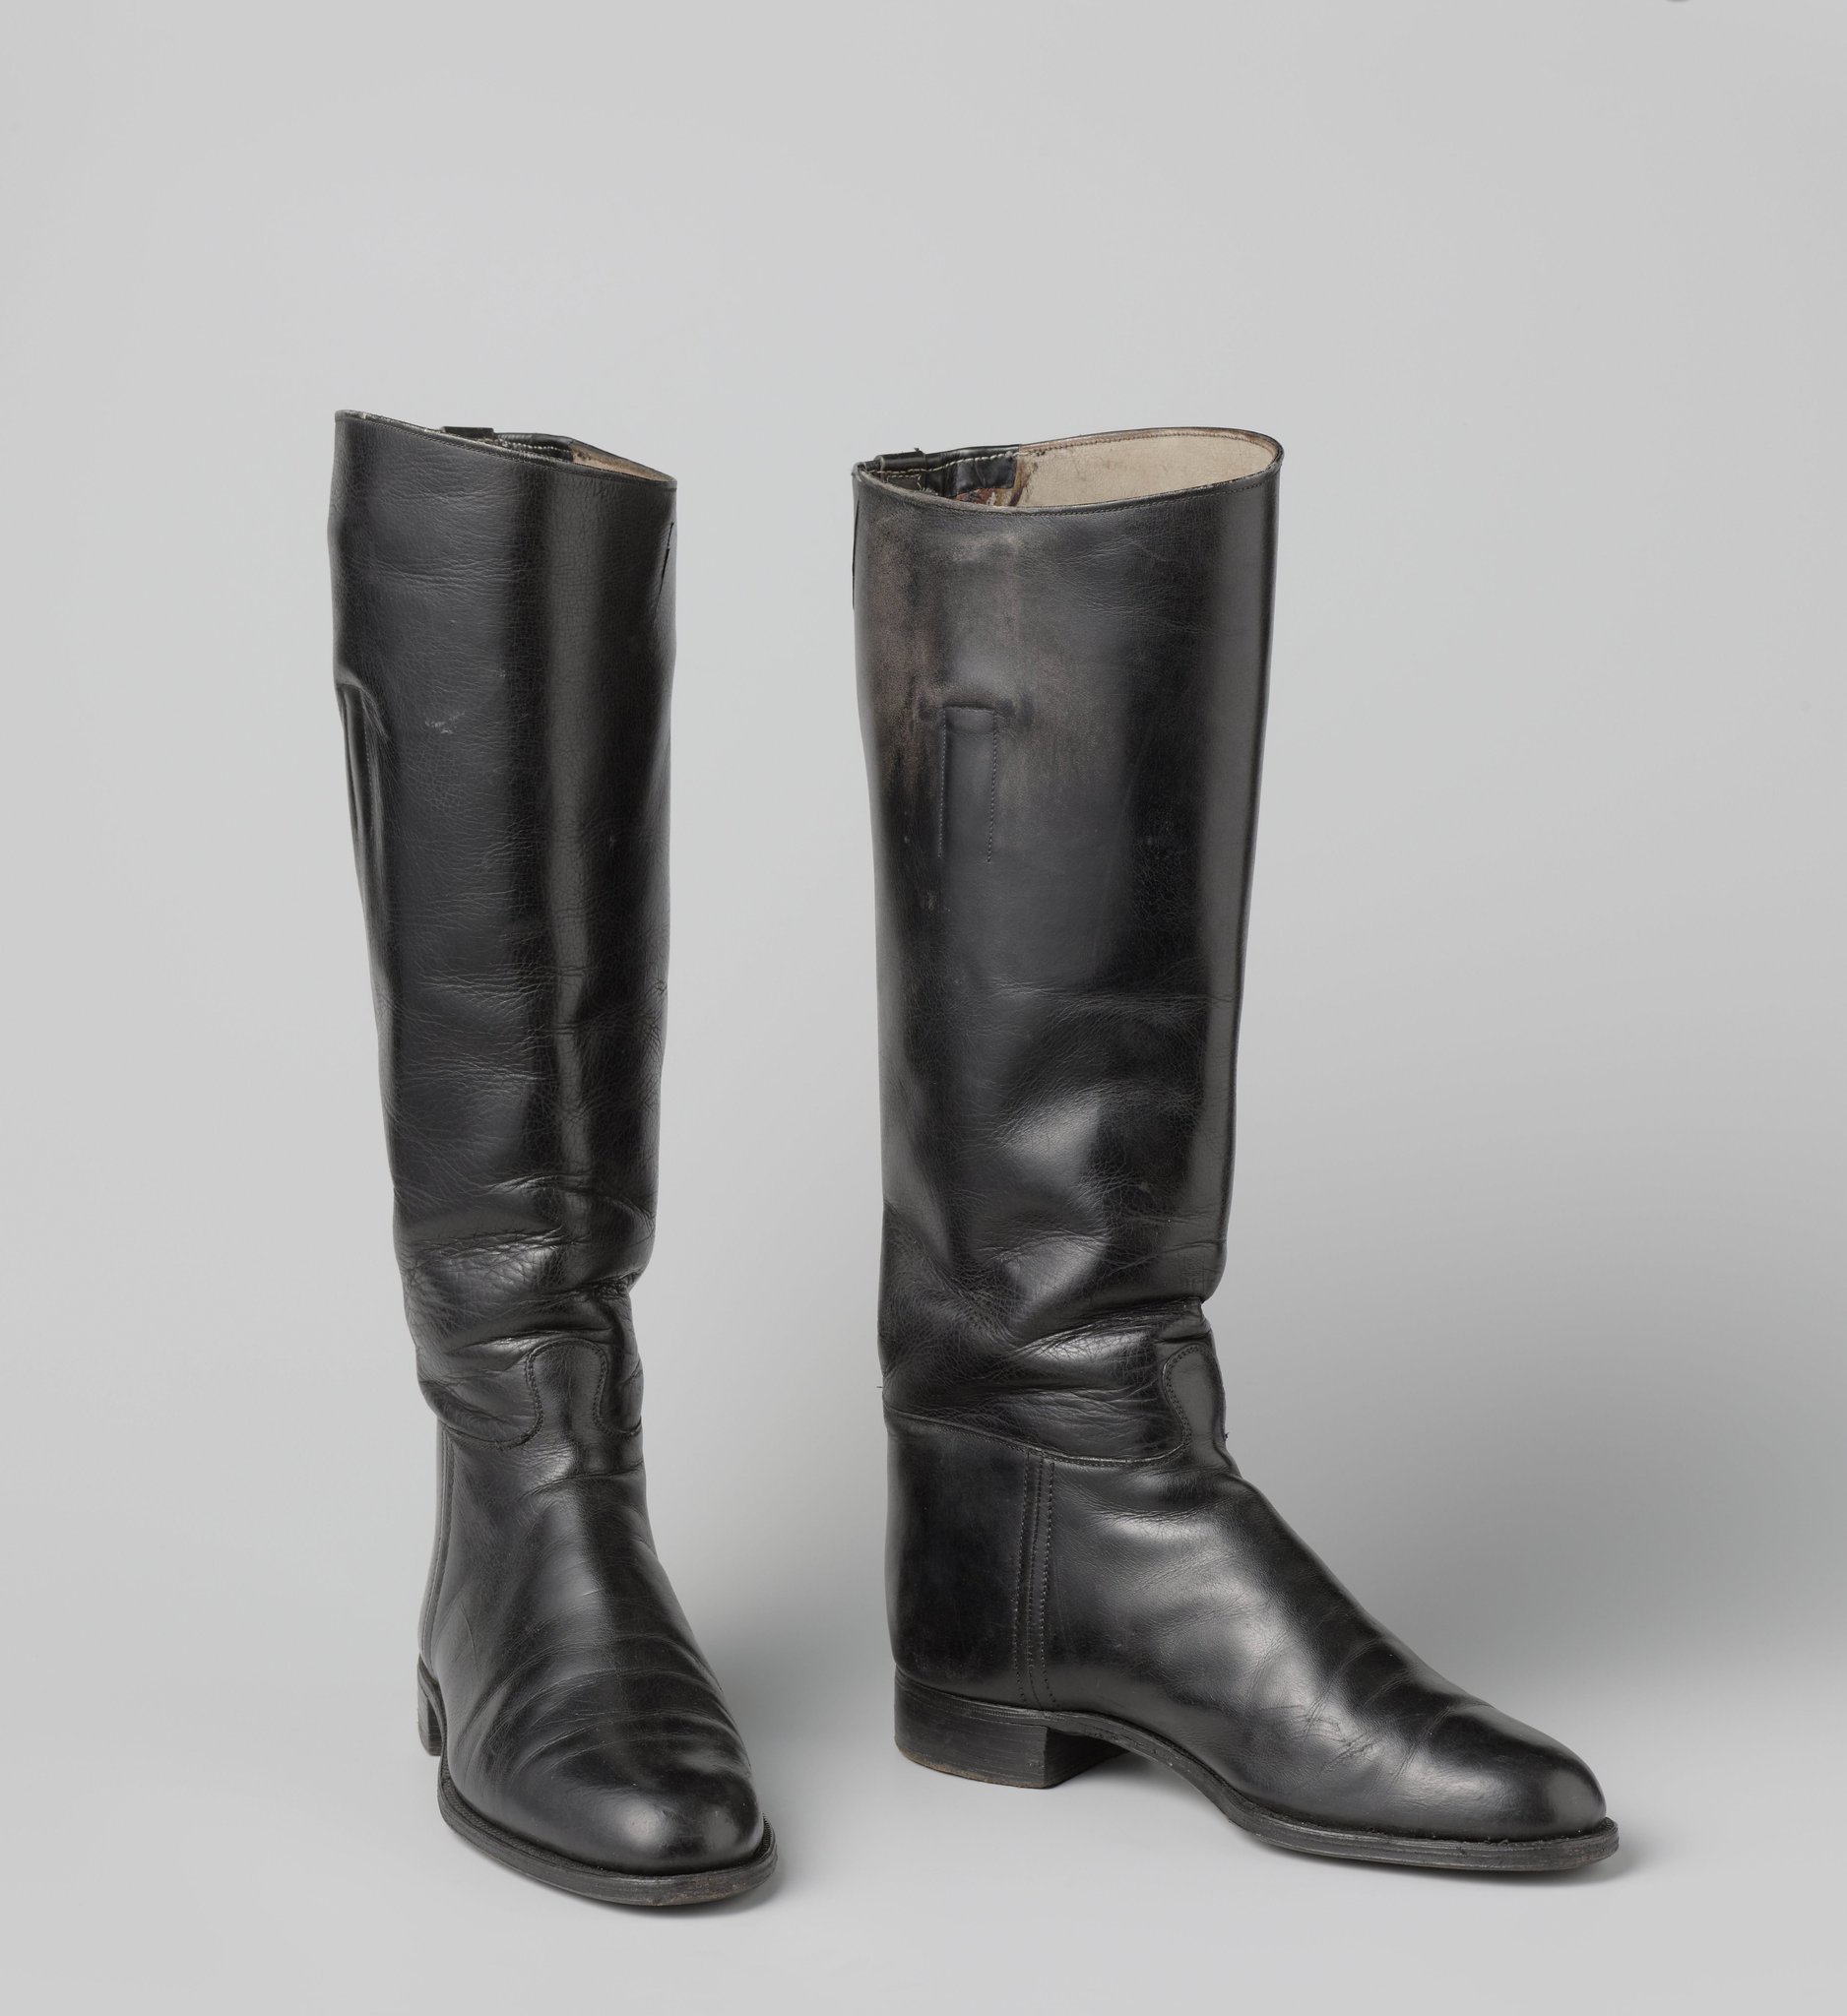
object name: sport clothing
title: Rijlaars van een rijkostuum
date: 1934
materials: leather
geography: netherlands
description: Rechterrijlaars, deel van een paar, behorende bij een rijkostuum, van zwart leer gevoerd met naturelkleurig leer. Adres: FRANSSEN/AMSTERDAM/LEIDSCHESTRAAT 80/H/.PRINSENGR.